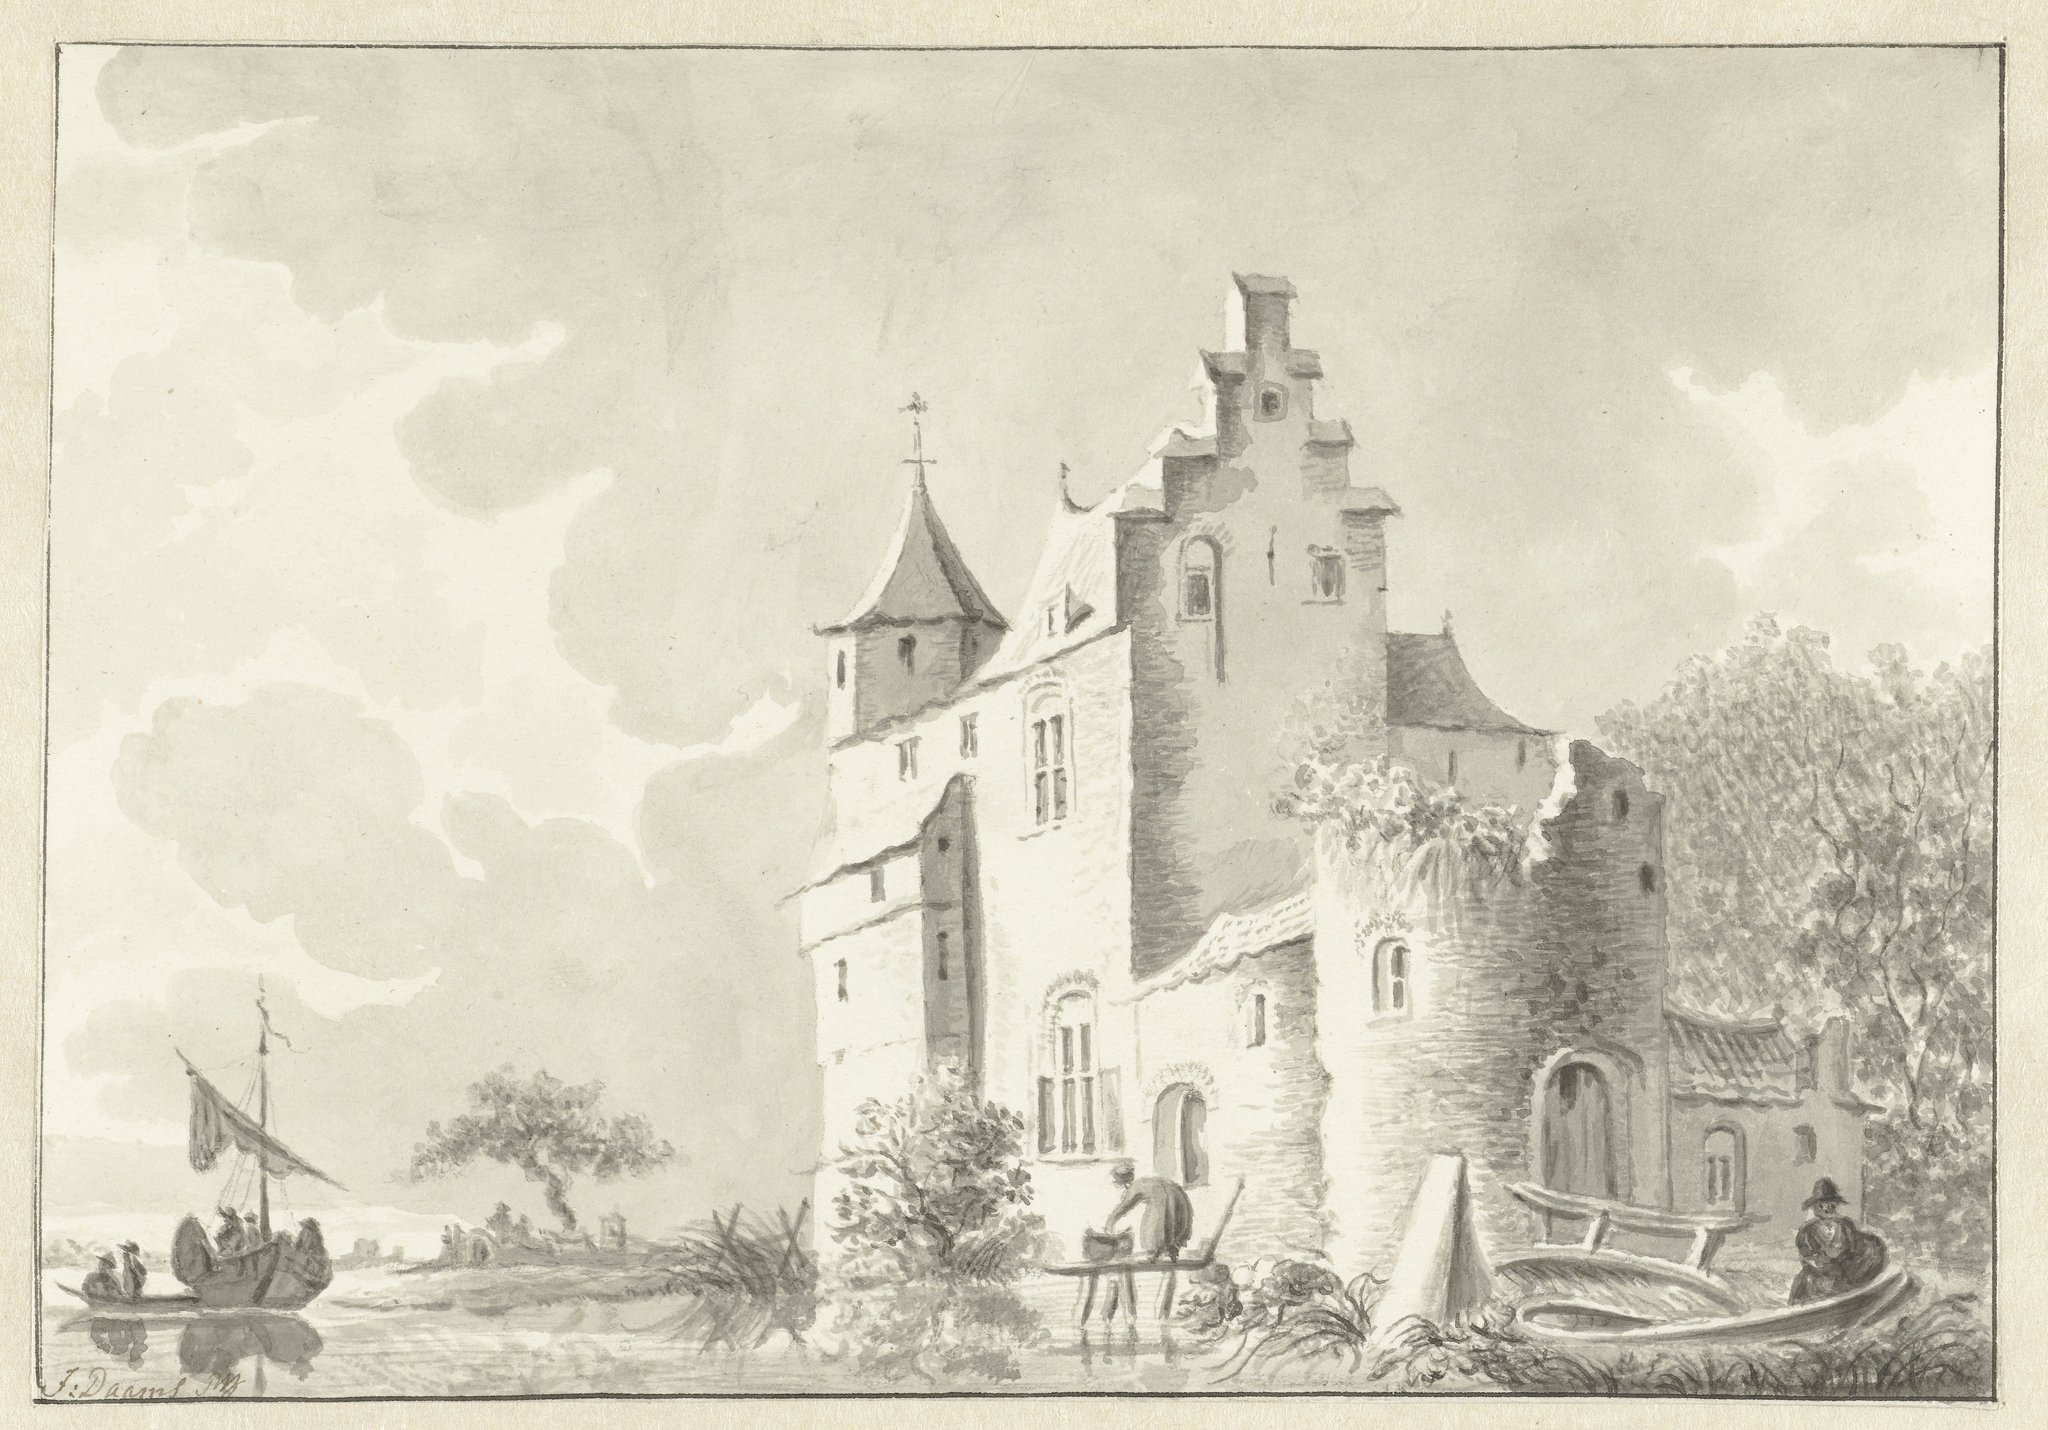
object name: drawing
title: Kasteel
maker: joost daams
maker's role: draughtsman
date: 1700-1800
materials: chalk, paper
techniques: brush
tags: castle